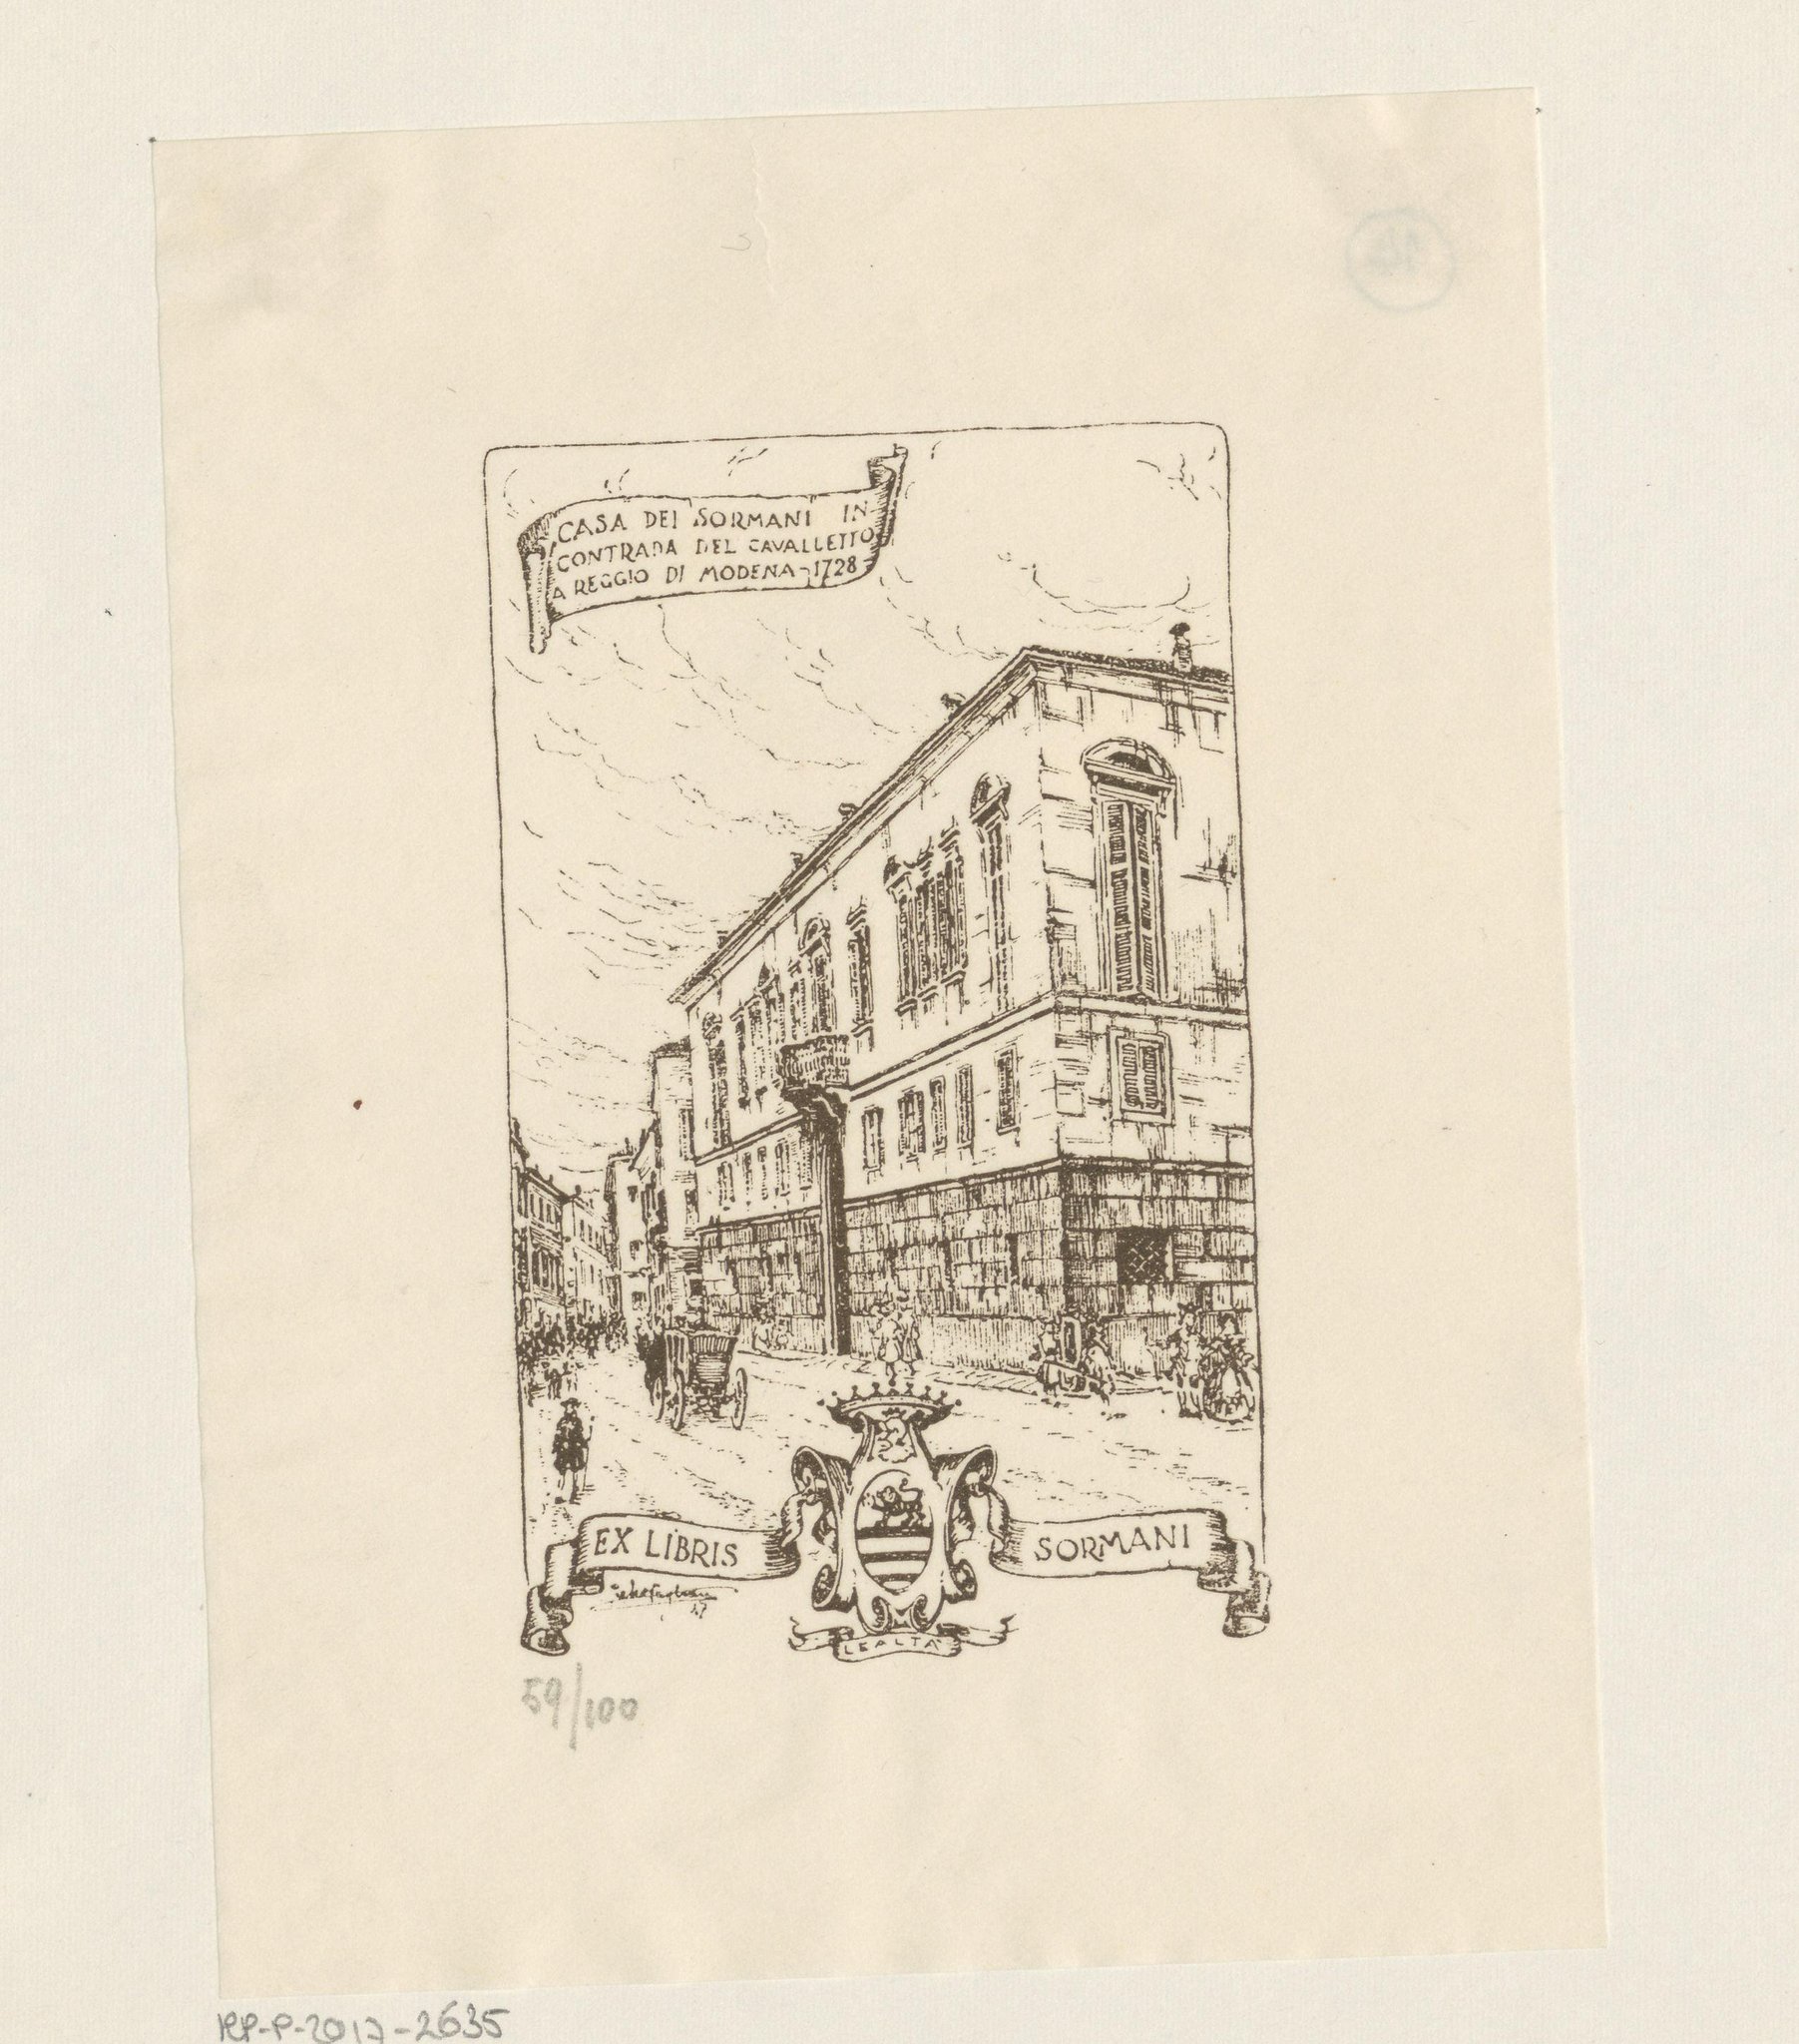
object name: bookplate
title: Ex libris van Sormani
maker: Anonymous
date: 1900-1999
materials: paper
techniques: lithograph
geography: italy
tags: alessandro sormani, hôtel, i.e. small palace in city, street